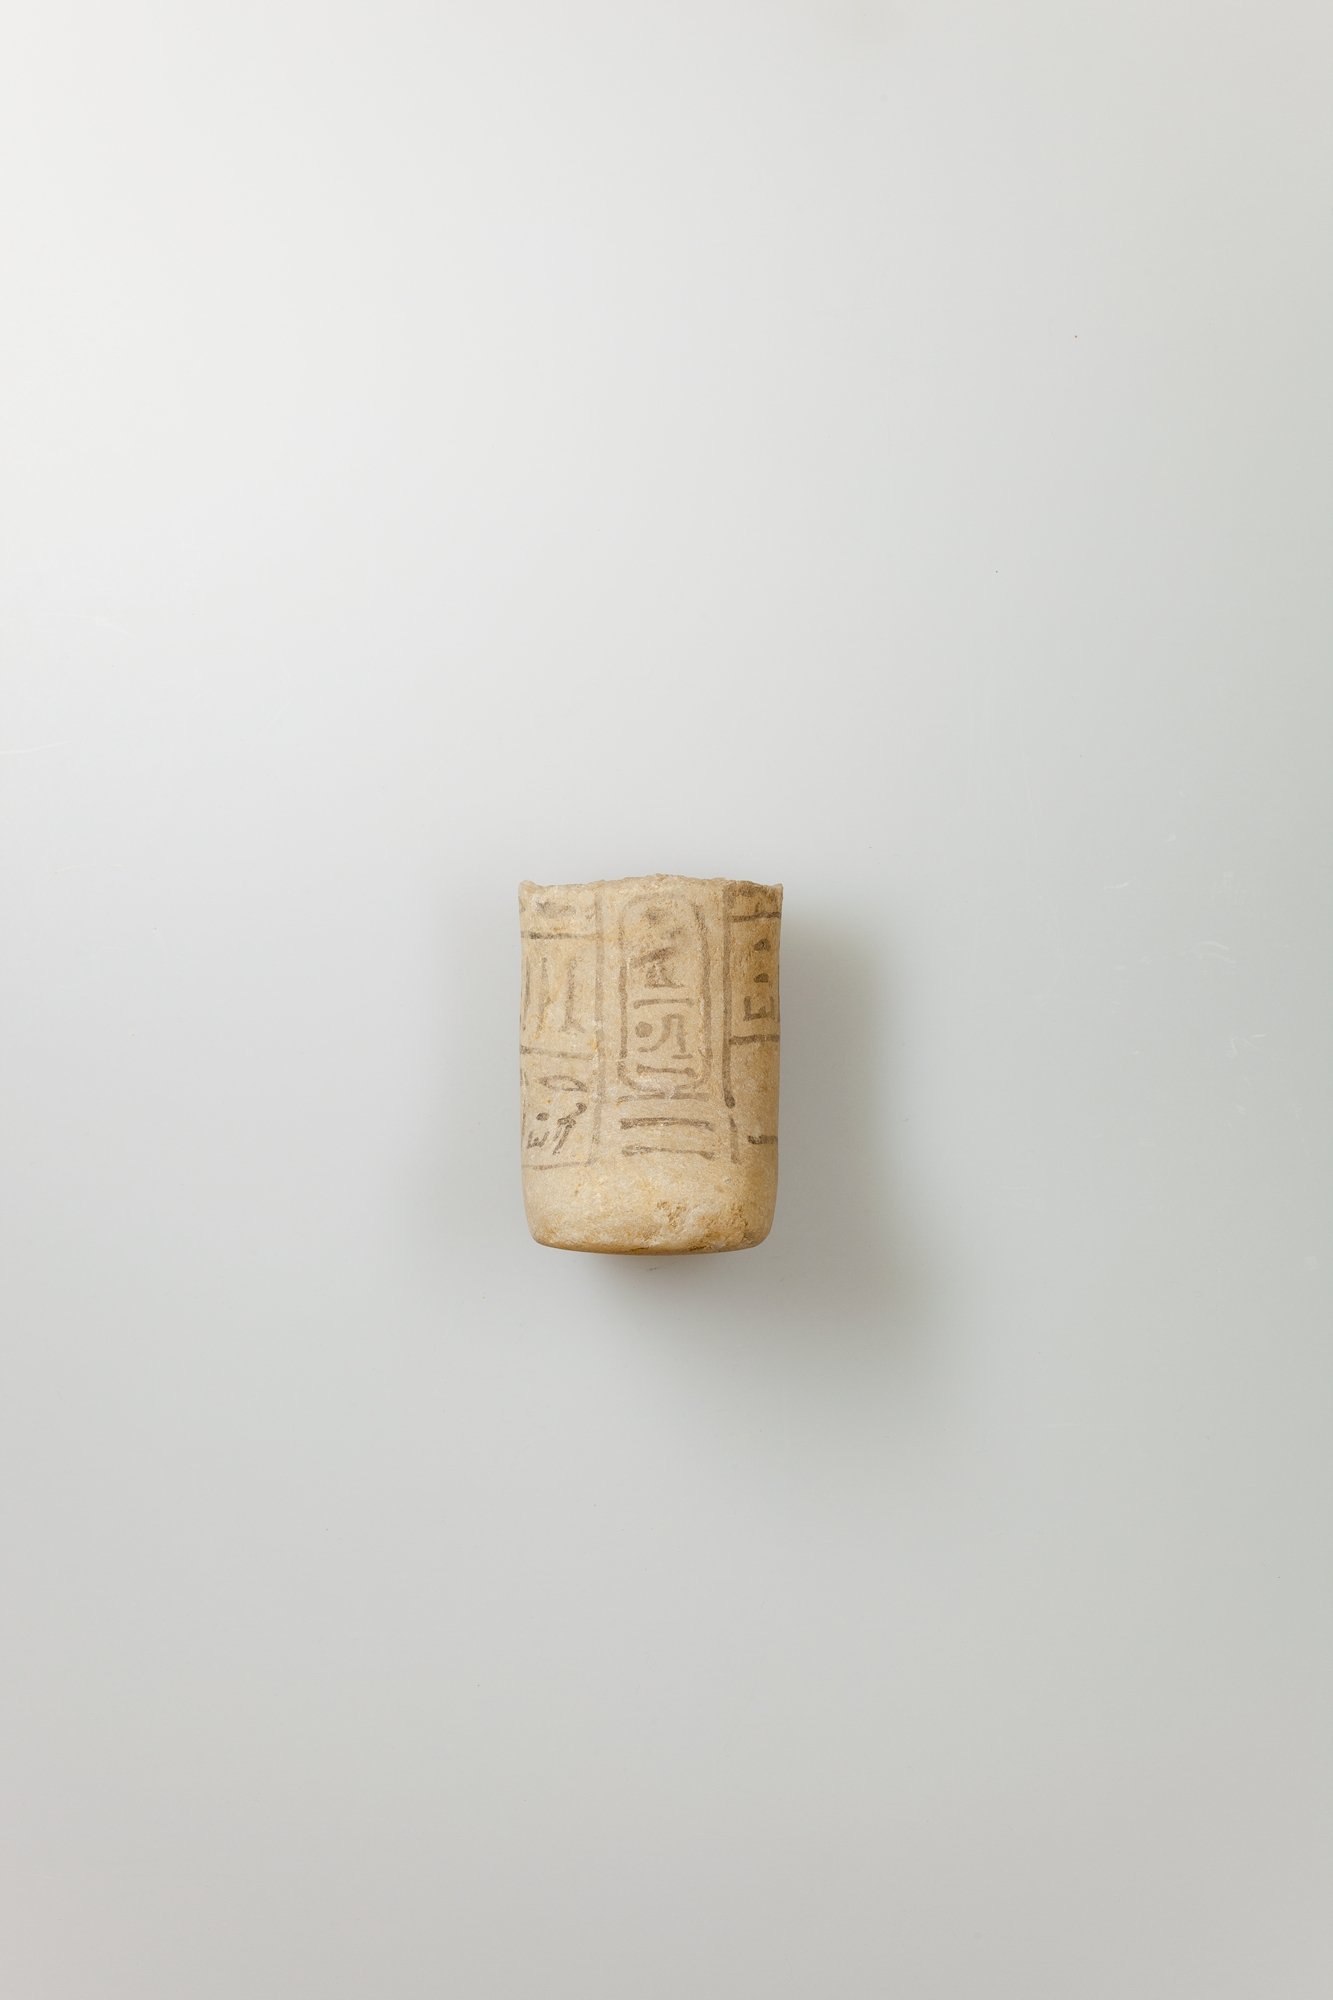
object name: shabti, siptah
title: Shabti of Siptah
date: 1194-1188 BCE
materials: stone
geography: egypt